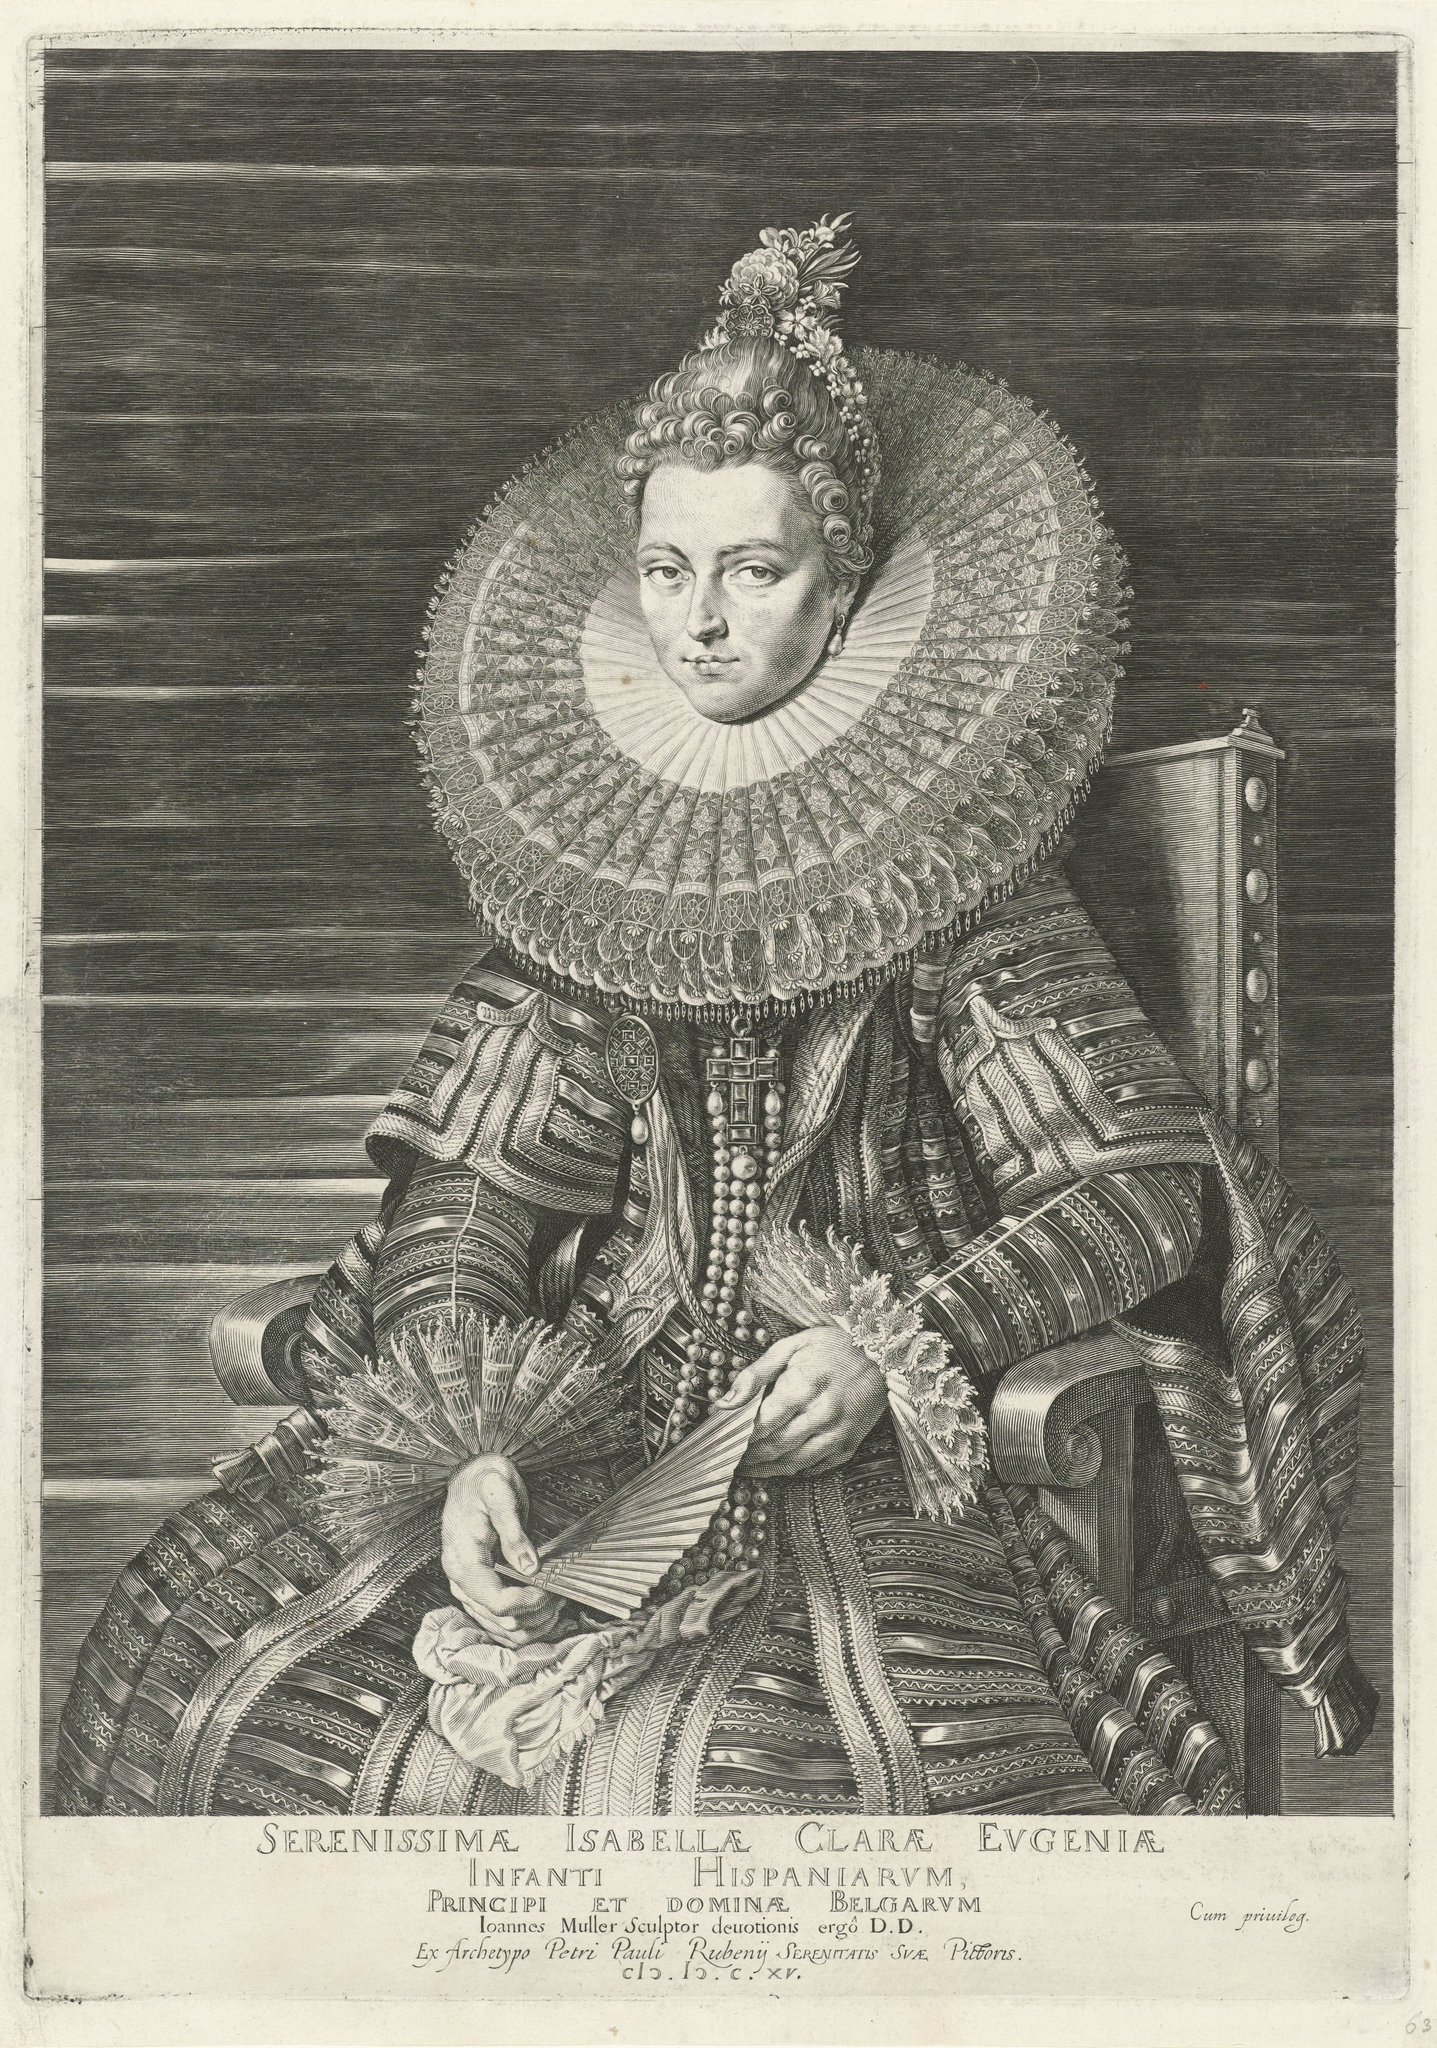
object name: print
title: Portret van Isabella Clara Eugenia, infante van Spanje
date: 1615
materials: paper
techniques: engraving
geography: amsterdam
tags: infante van spanje isabella clara eugenia, neck-gear ~ clothing (with name) (+ women's clothes), fan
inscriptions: collector's mark: Lugt 240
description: Portret van Isabella Clara Eugenia, infante van Spanje en landvoogdes van de Nederlanden, zittende in een stoel. Zij draagt een kanten kraag en houdt een waaier in haar handen.